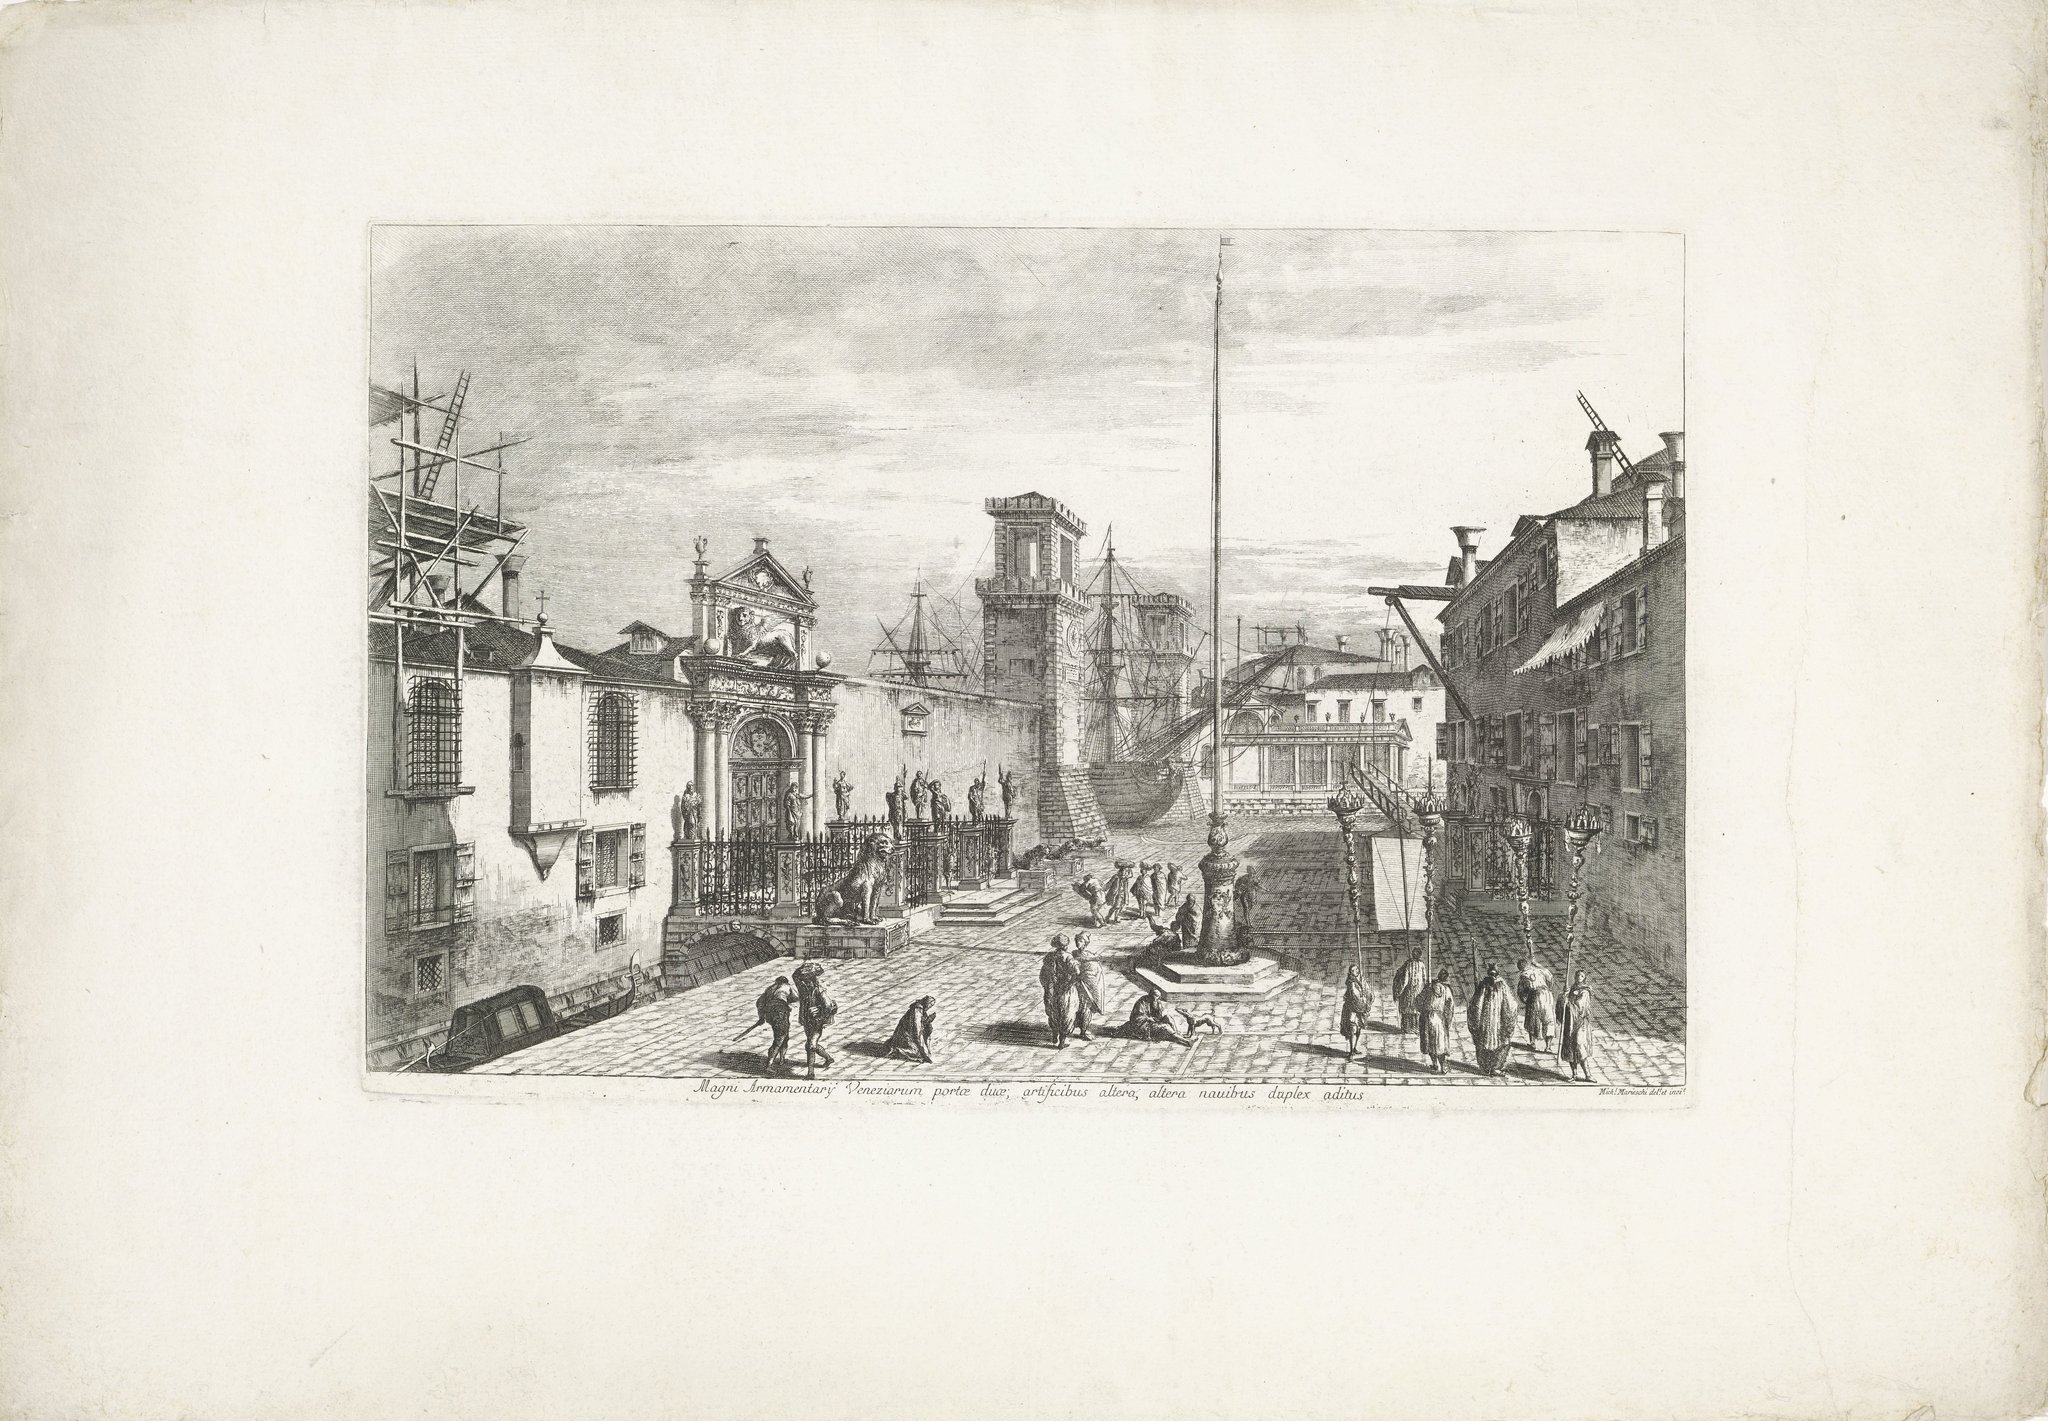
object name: print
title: Magni Armamentarij Veneziarum portae duae (...)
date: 1741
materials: paper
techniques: engraving, etching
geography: venice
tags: city-view, and landscape with man-made constructions, gate, entrance, ammunition store, arsenal, venice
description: Prent maakt deel uit van een reeks van prenten met gezichten op Venetië.